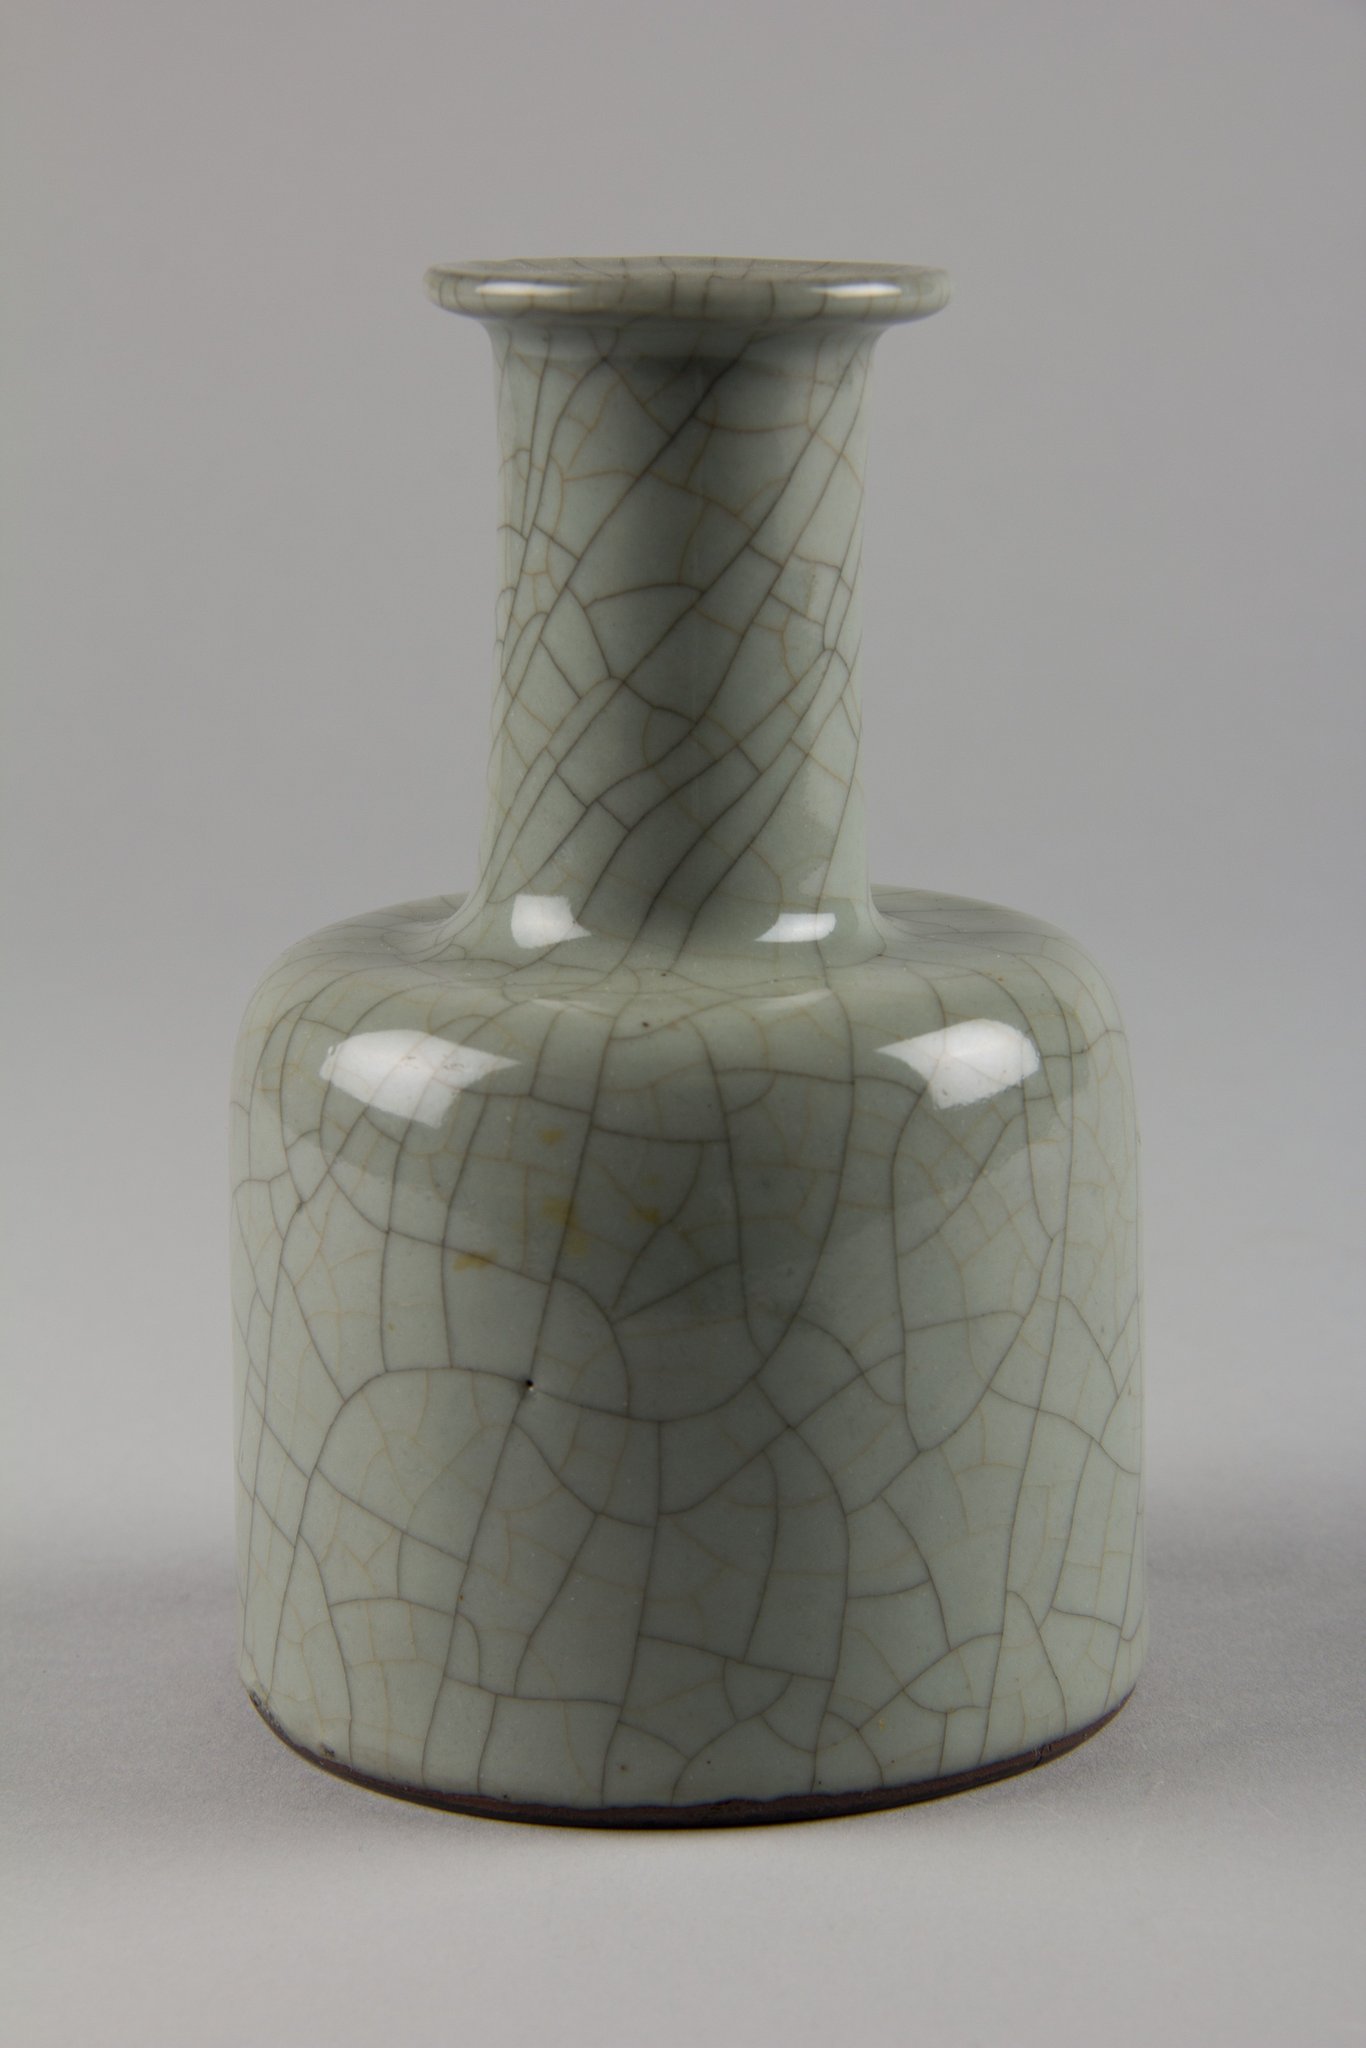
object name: vase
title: Mallet-shaped vase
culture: chinese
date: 1701-1800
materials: glaze, porcelain